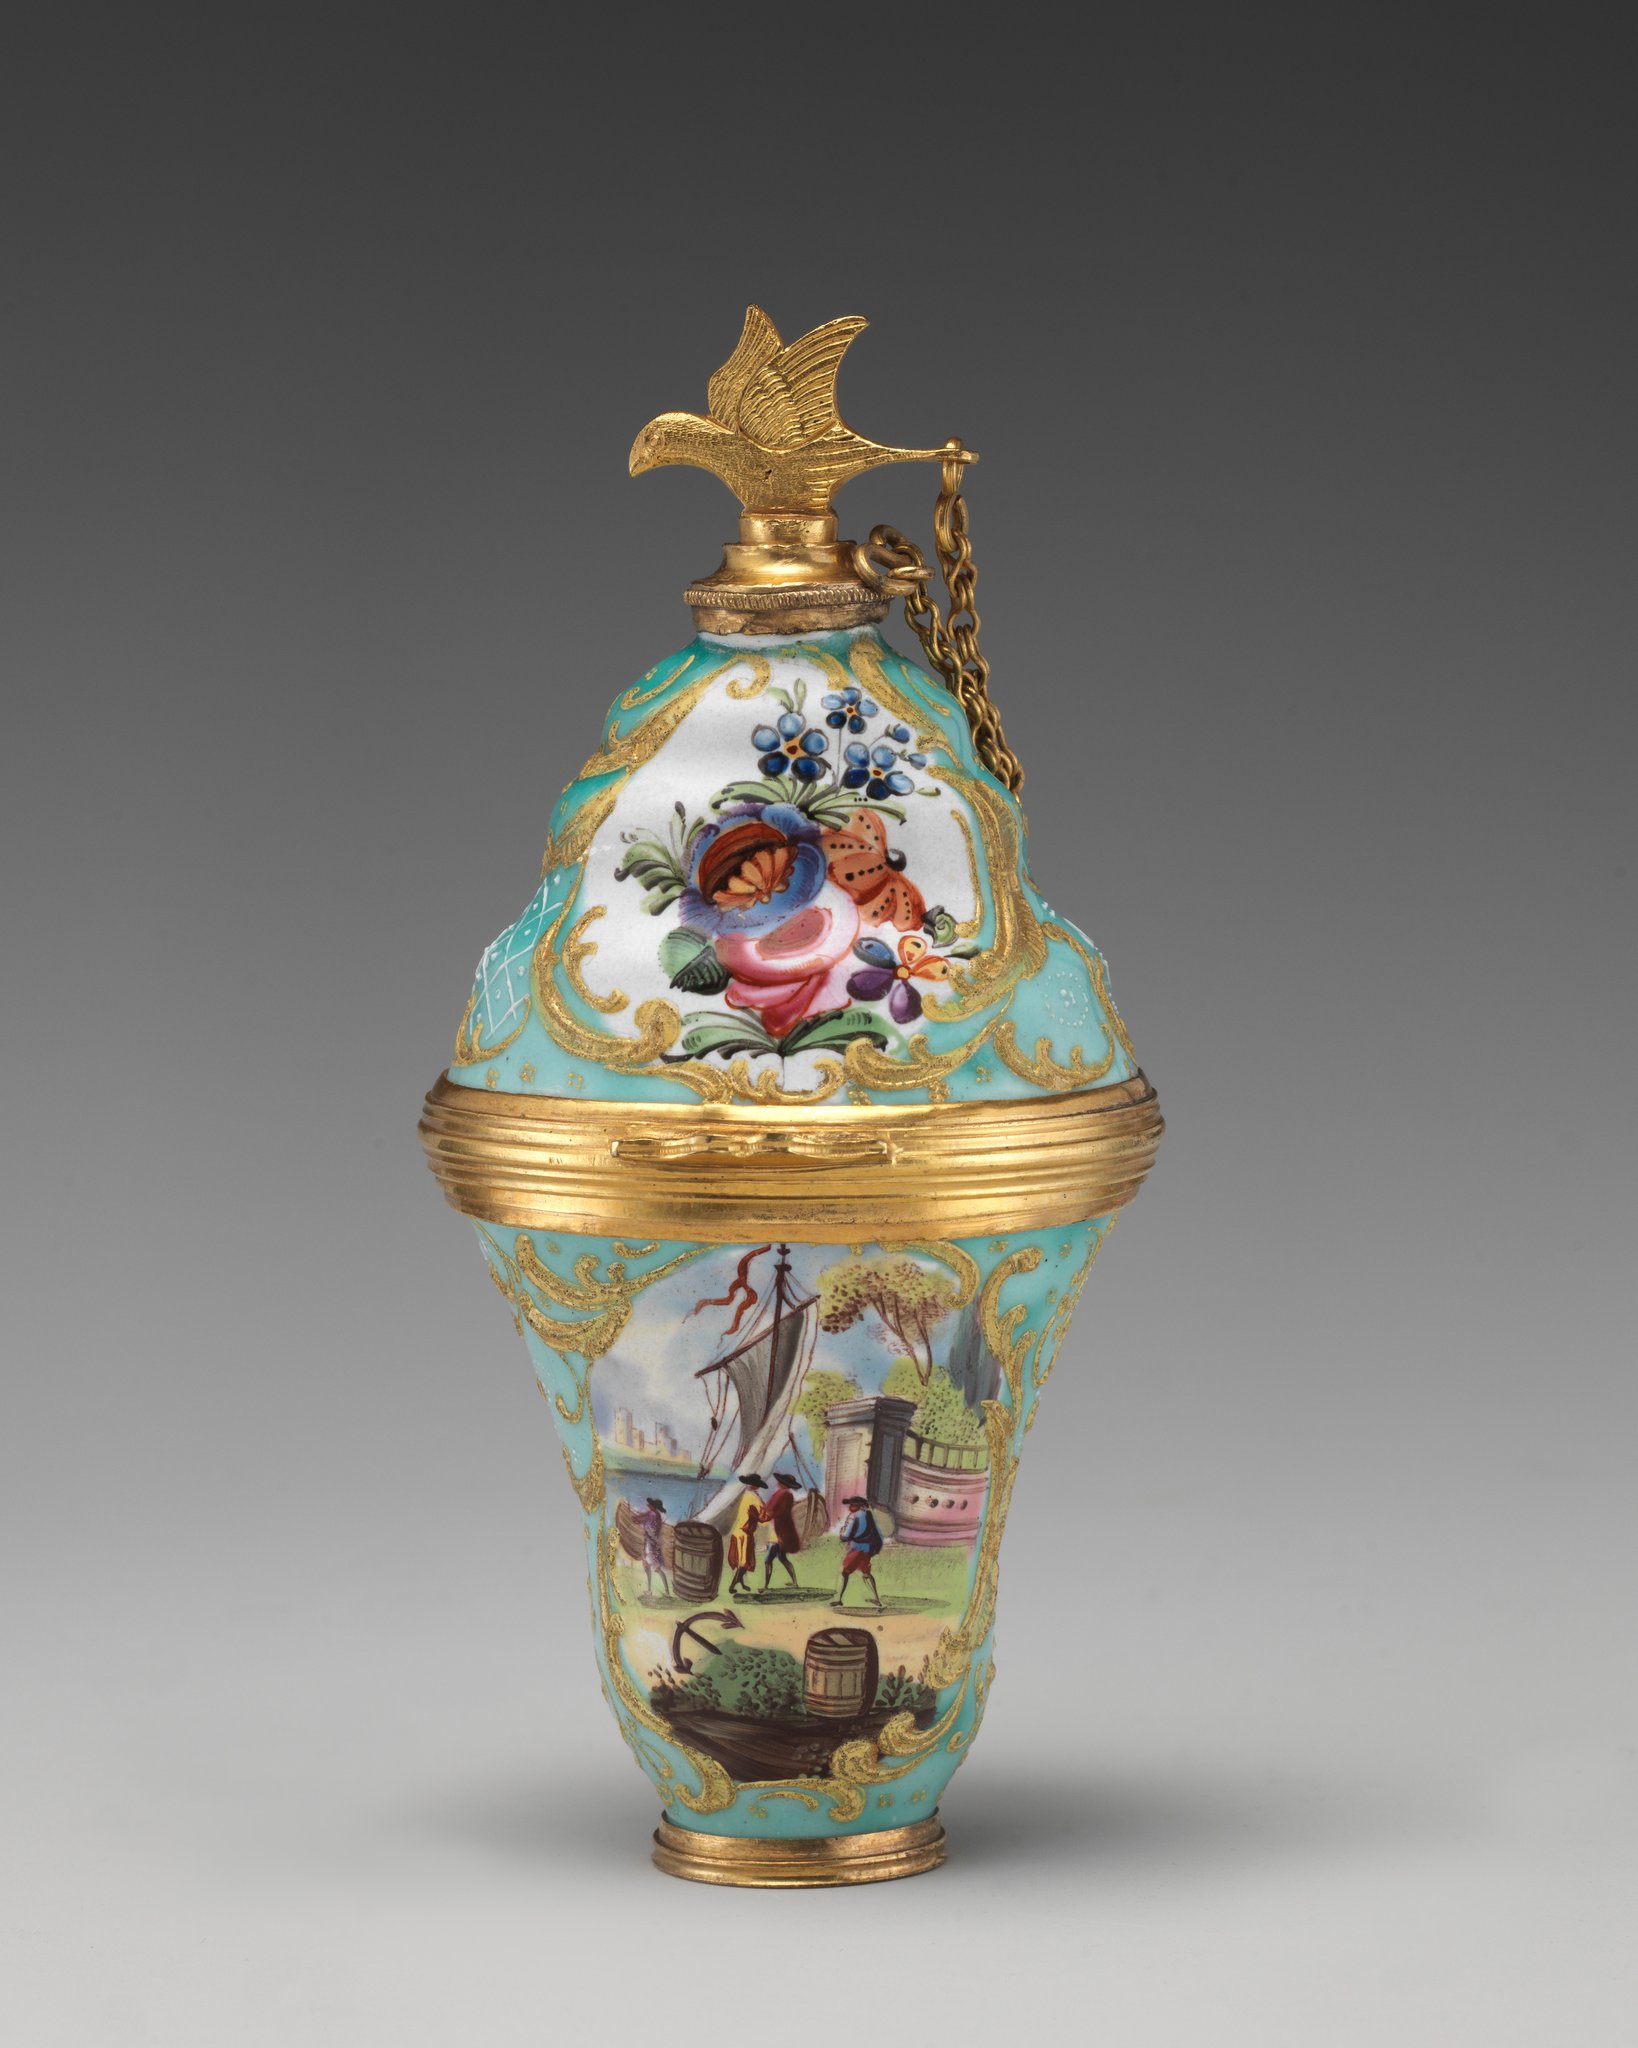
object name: scent bottle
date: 1765-1770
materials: copper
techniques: enamel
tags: men,sheep,trees,boats